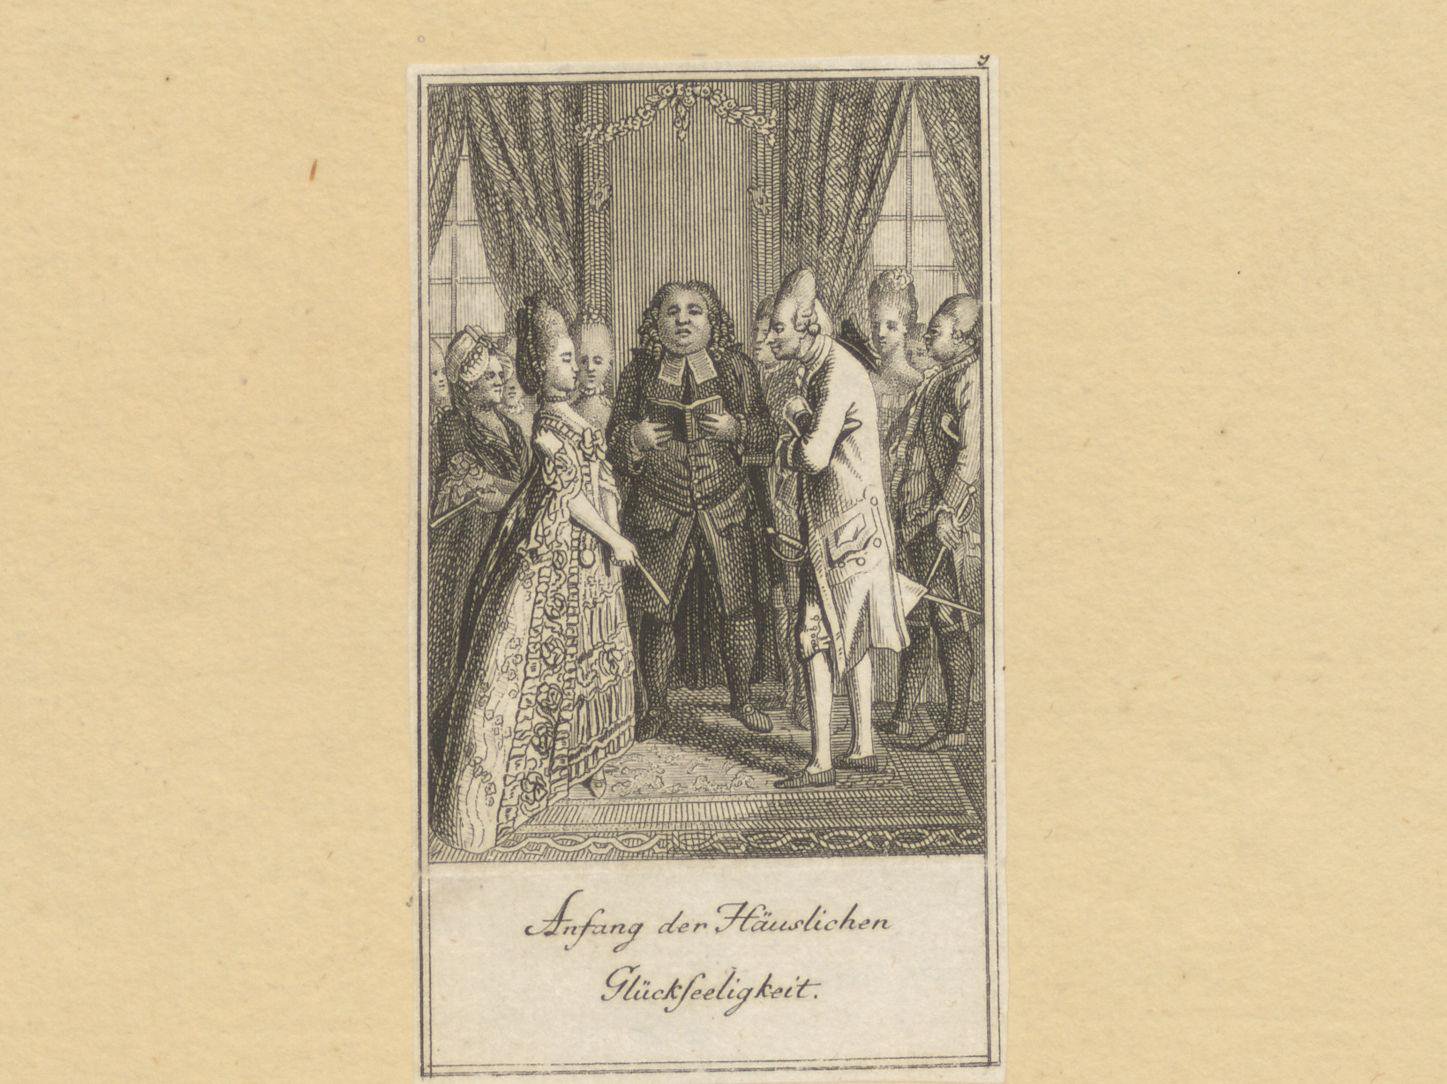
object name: print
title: Dominee trouwt een man en een vrouw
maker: daniel berger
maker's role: print maker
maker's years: 1744-1824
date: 1773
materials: paper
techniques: etching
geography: berlin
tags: 11q73262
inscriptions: collector's mark: Lugt 2228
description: Prent afkomstig uit: Genealogischer Calender auf das Jahr 1774. Mit Genehmigung der Königlichen Academie der Wissenschaften zu Berlin herausgegeben. Negende scène uit de serie 'Das Leben eines Lüderlichen', bestaand uit twaalf scènes, gedrukt van een koperplaat.